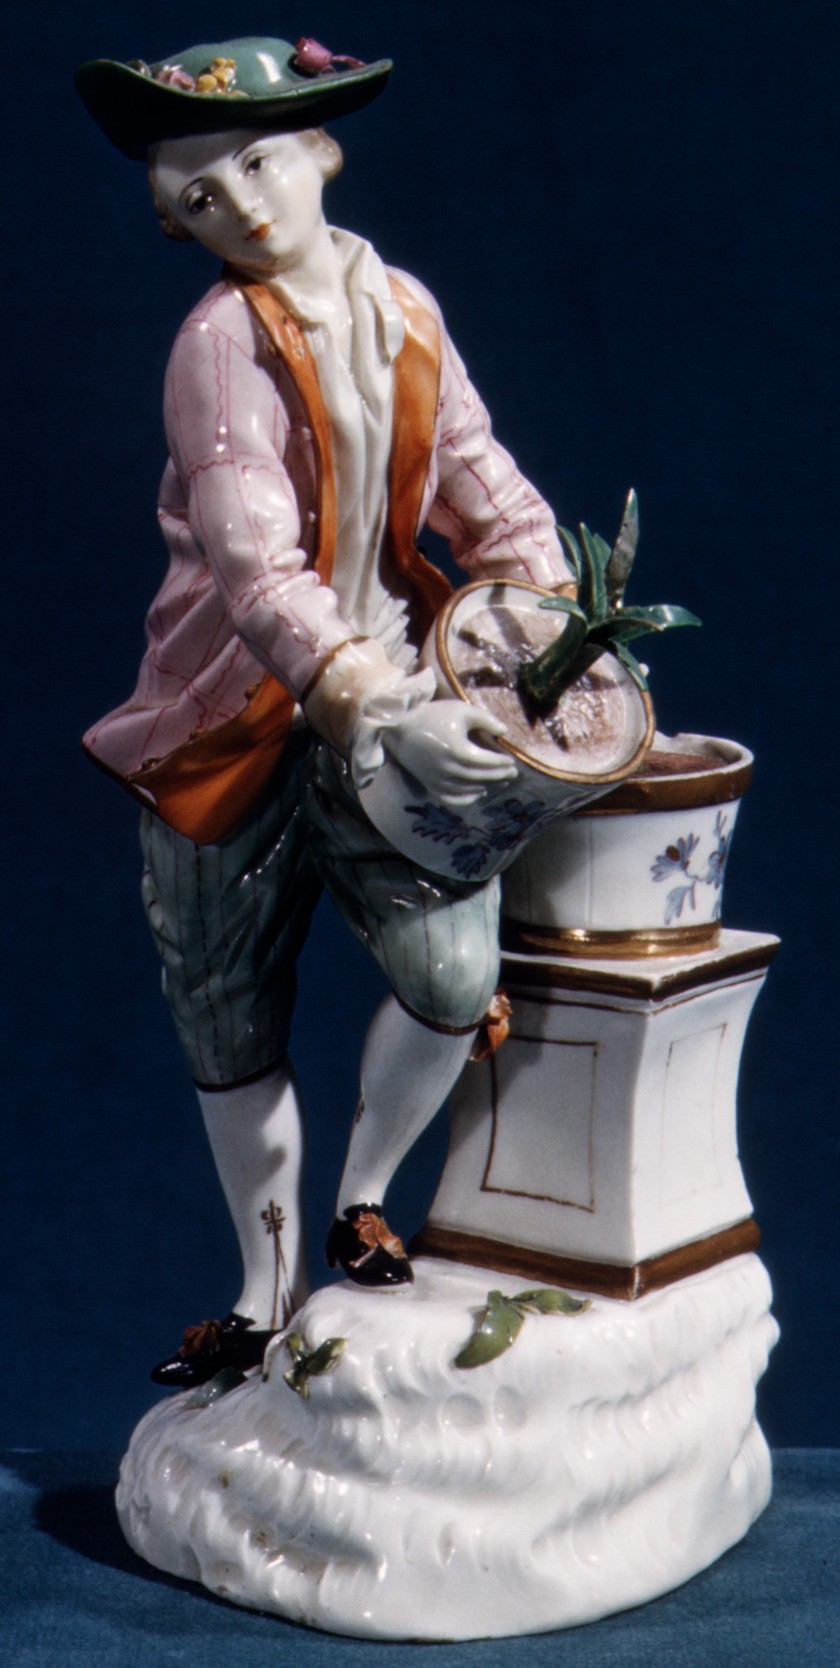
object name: figure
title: Gardener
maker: fulda pottery and porcelain manufactory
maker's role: manufactory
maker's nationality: german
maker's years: 1764-1789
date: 1770-1775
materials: hard paste porcelain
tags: boys,plants,gardeners